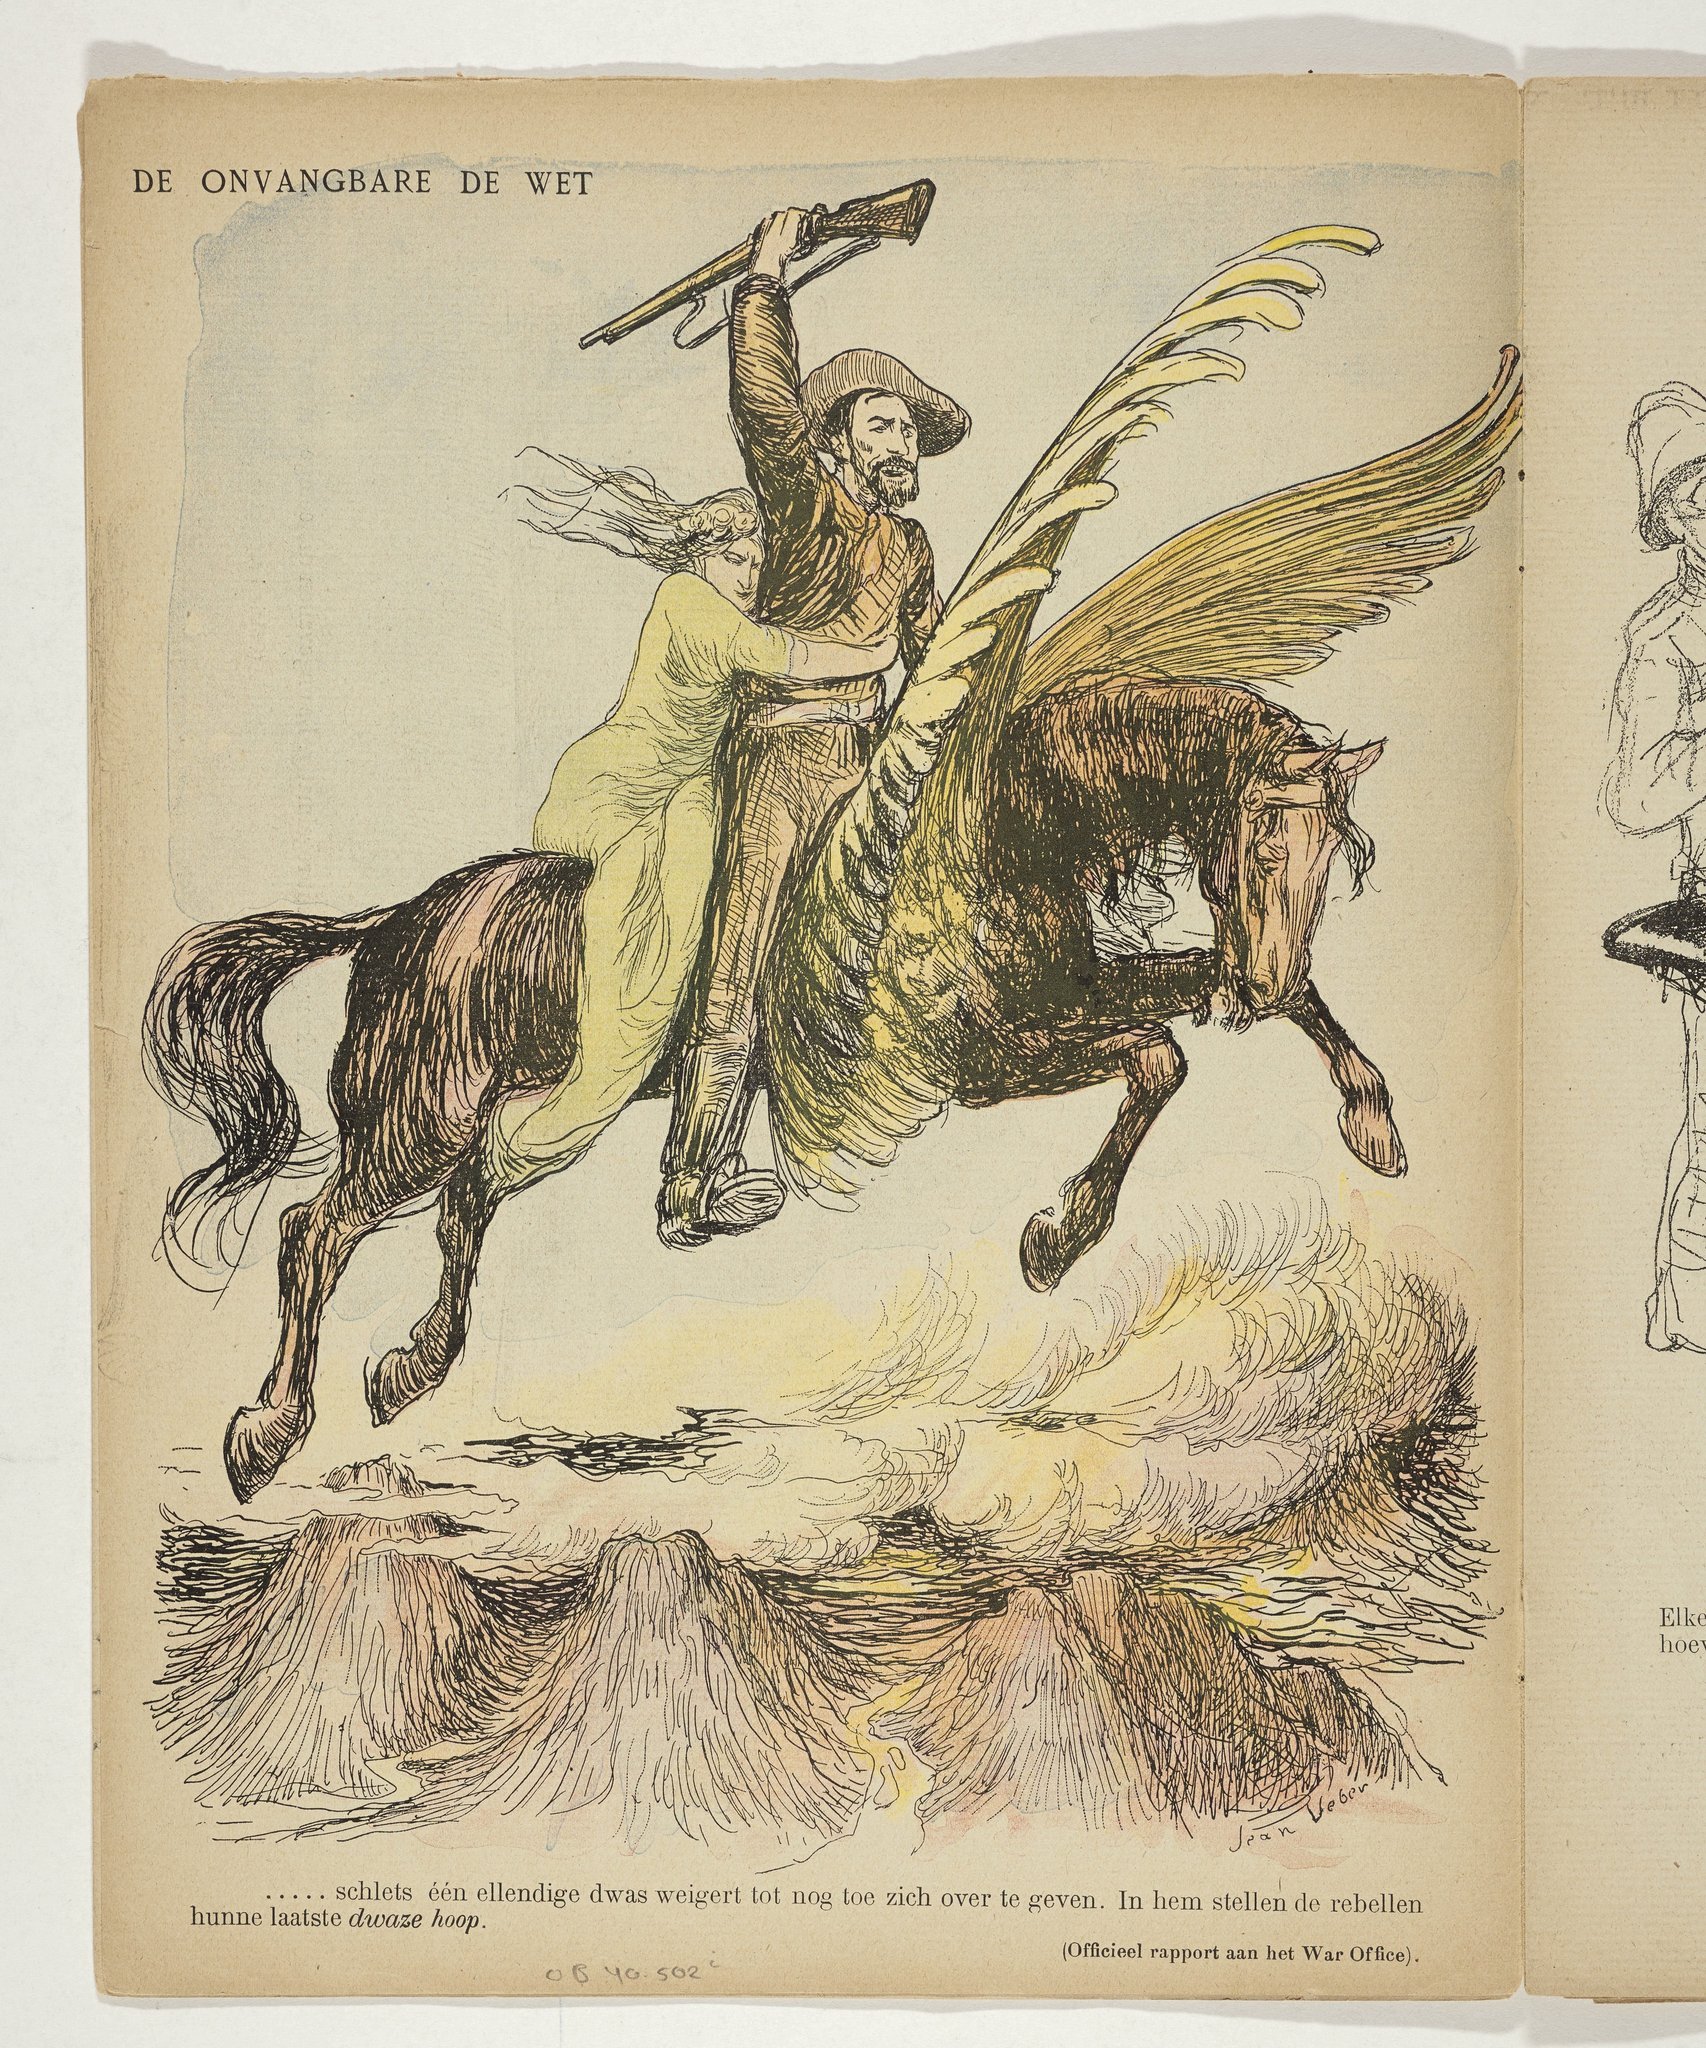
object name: cartoon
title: De onvangbare De Wet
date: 1901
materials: paper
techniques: lithograph, letterpress printing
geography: paris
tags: politician, hope; 'speranza', 'speranza delle fatiche' (ripa), fabulous animals ~ hoofed animals: winged horse, political caricatures and satires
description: Prent maakt deel uit van een tijdschrift met spotprenten op de Tweede Boerenoorlog. Met drieregelig onderschrift: ..... schlets één ellendige dwas weigert tot nog toe zich over te geven. In hem stellen de rebellen hunne laatste dwaze hoop. (Officieel rapport aan het War Office).